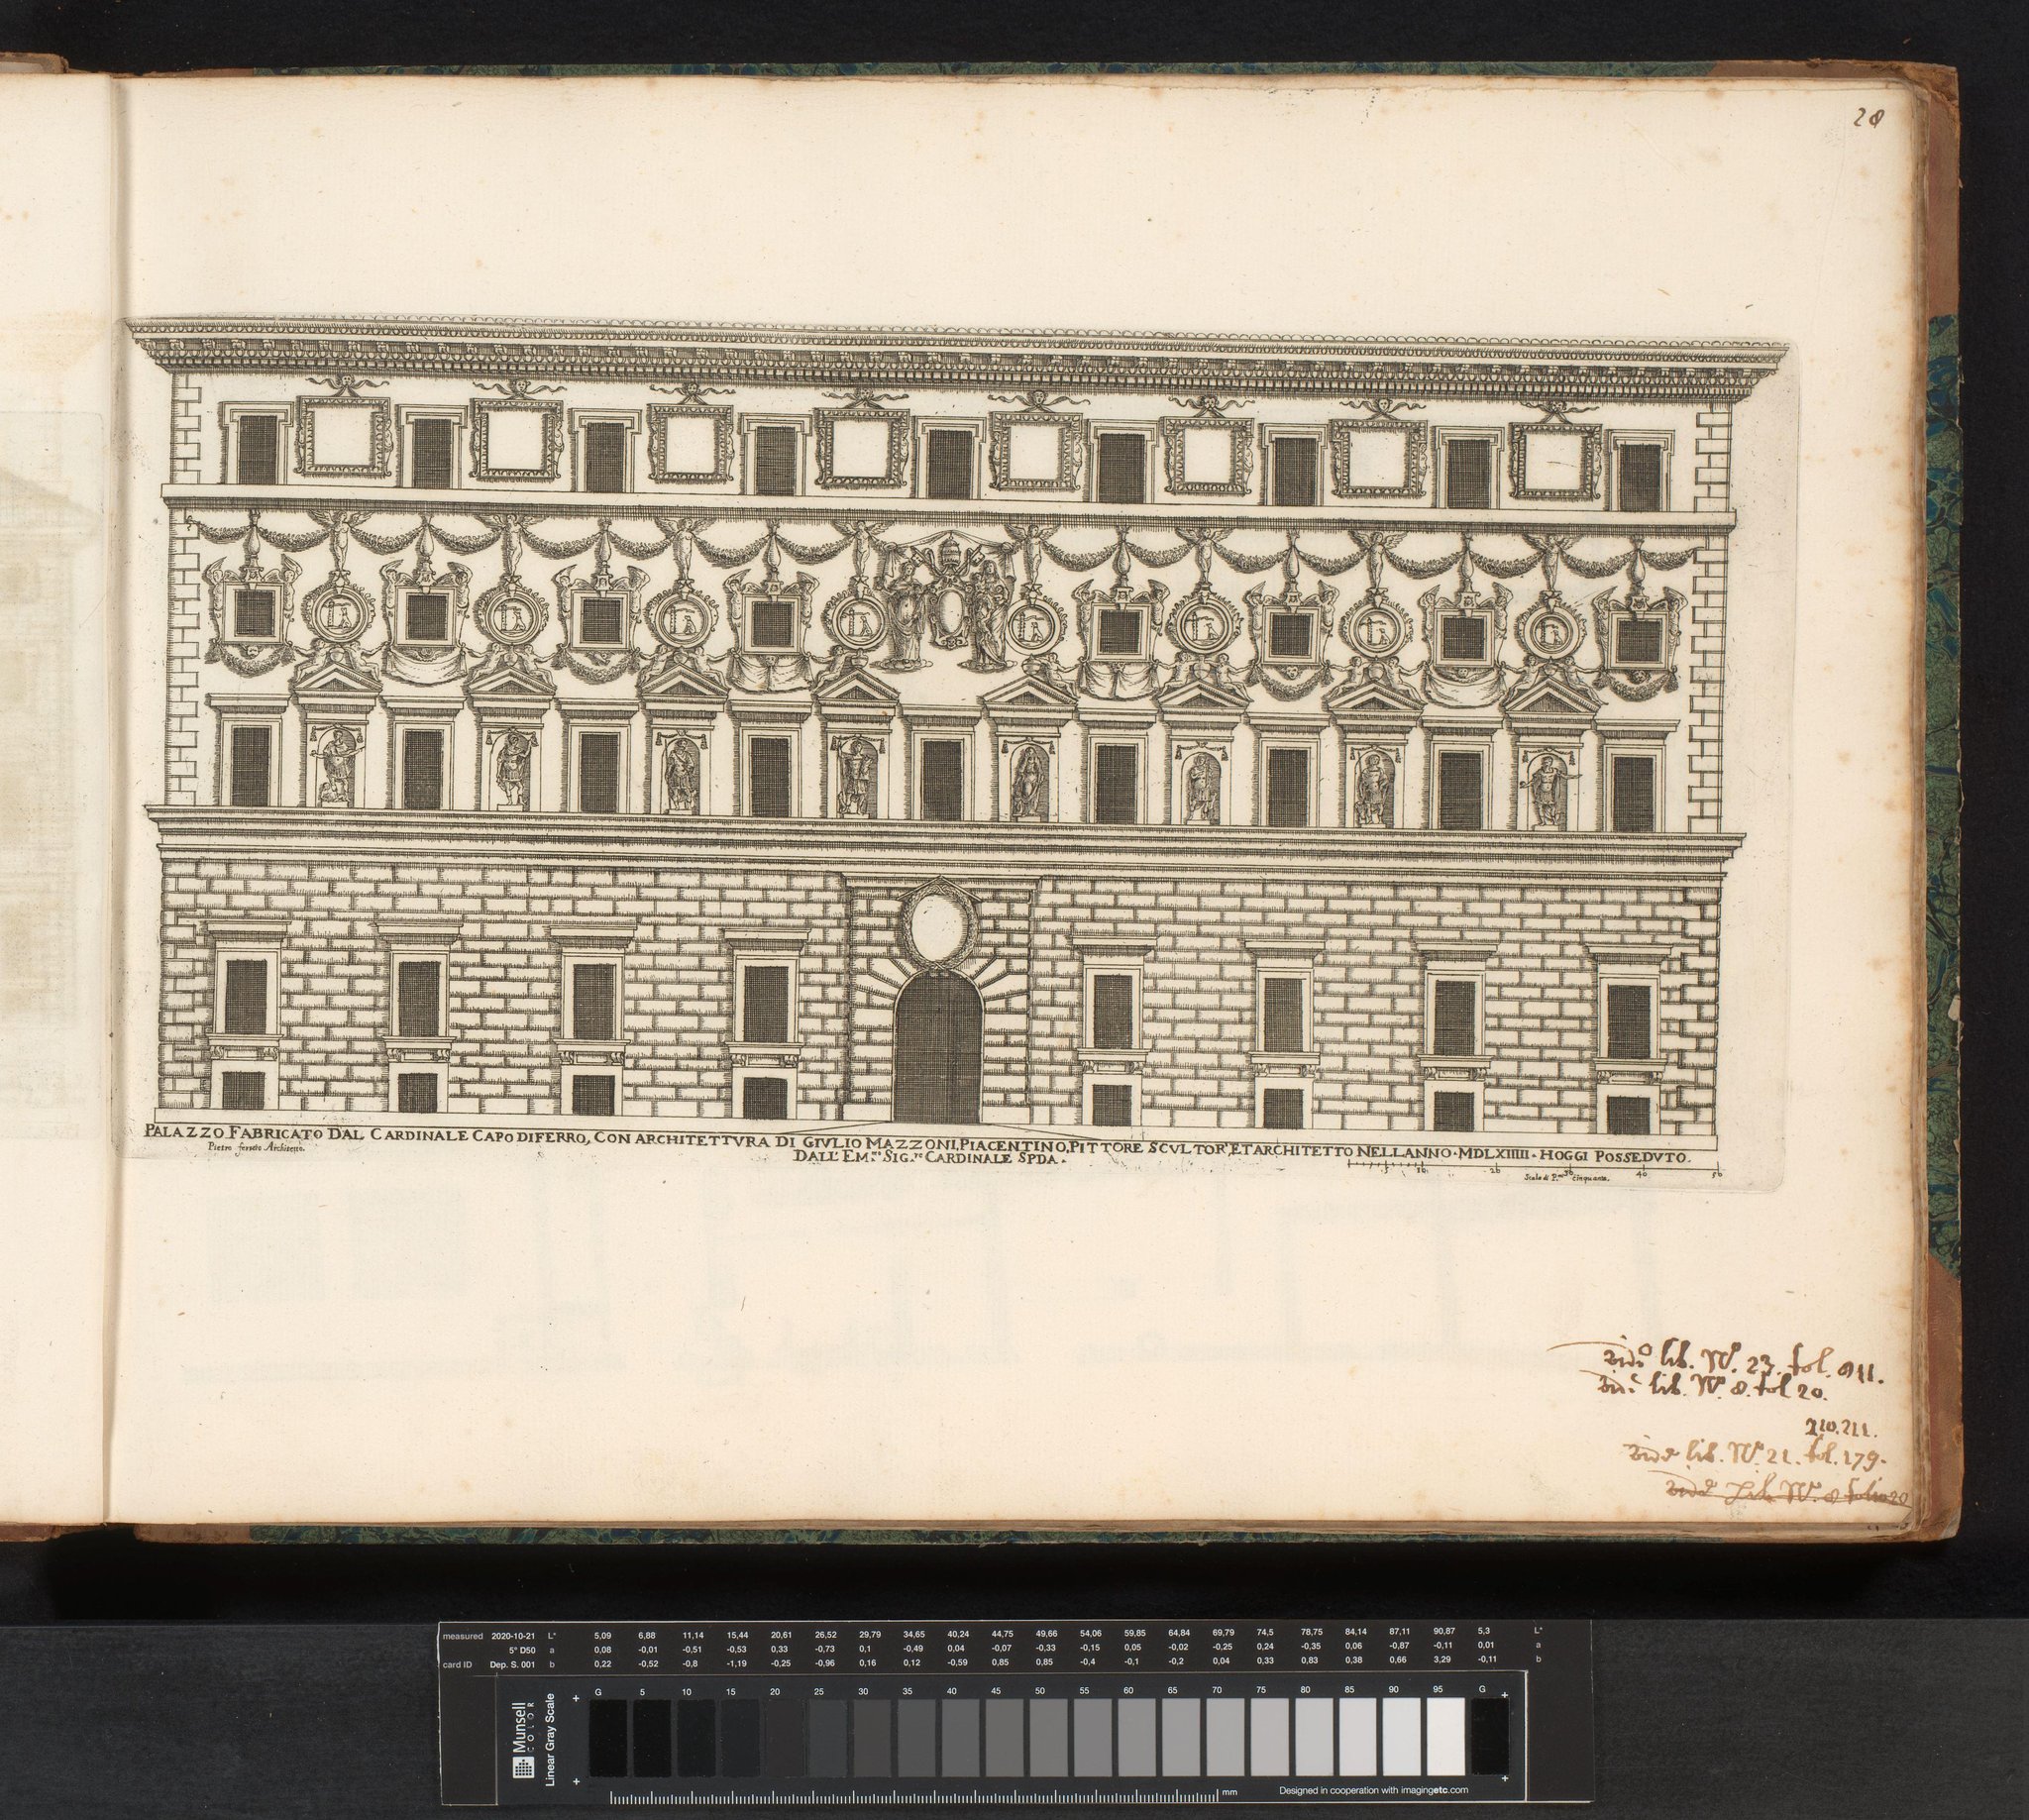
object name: album leaf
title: Palazzo fabricato dal Cardinale Capodiferr (...)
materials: paper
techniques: etching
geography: italy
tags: palace, façade (of house or building)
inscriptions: inscription: ‘Ende lib. No. 23. fol. 811./ Ende lib. No. 8. fol. 20...’, number: ‘28’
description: Deze prent maakt deel uit van de reeks getiteld: Palazzi di Roma. Deze reeks bestaat uit twee boeken. Boek één getiteld: Palazzi di Roma dei più celebri architetti..., bestaat uit 44 prenten die worden toegeschreven aan Giovanni Battista Falda (naam staat enkel op prent 27) en uitgegeven door Giovanni Giacomo de'Rossi. Deze 44 prenten zijn bekend in twee staten (met en zonder nummer). Boek twee getiteld: Nuovi disegni dell'architetture... libro secondo, bevat 66 prenten door Giovanni Battista Falda en Simone Felice. Deze 66 prenten zijn bekend in twee staten (met en zonder nummer).